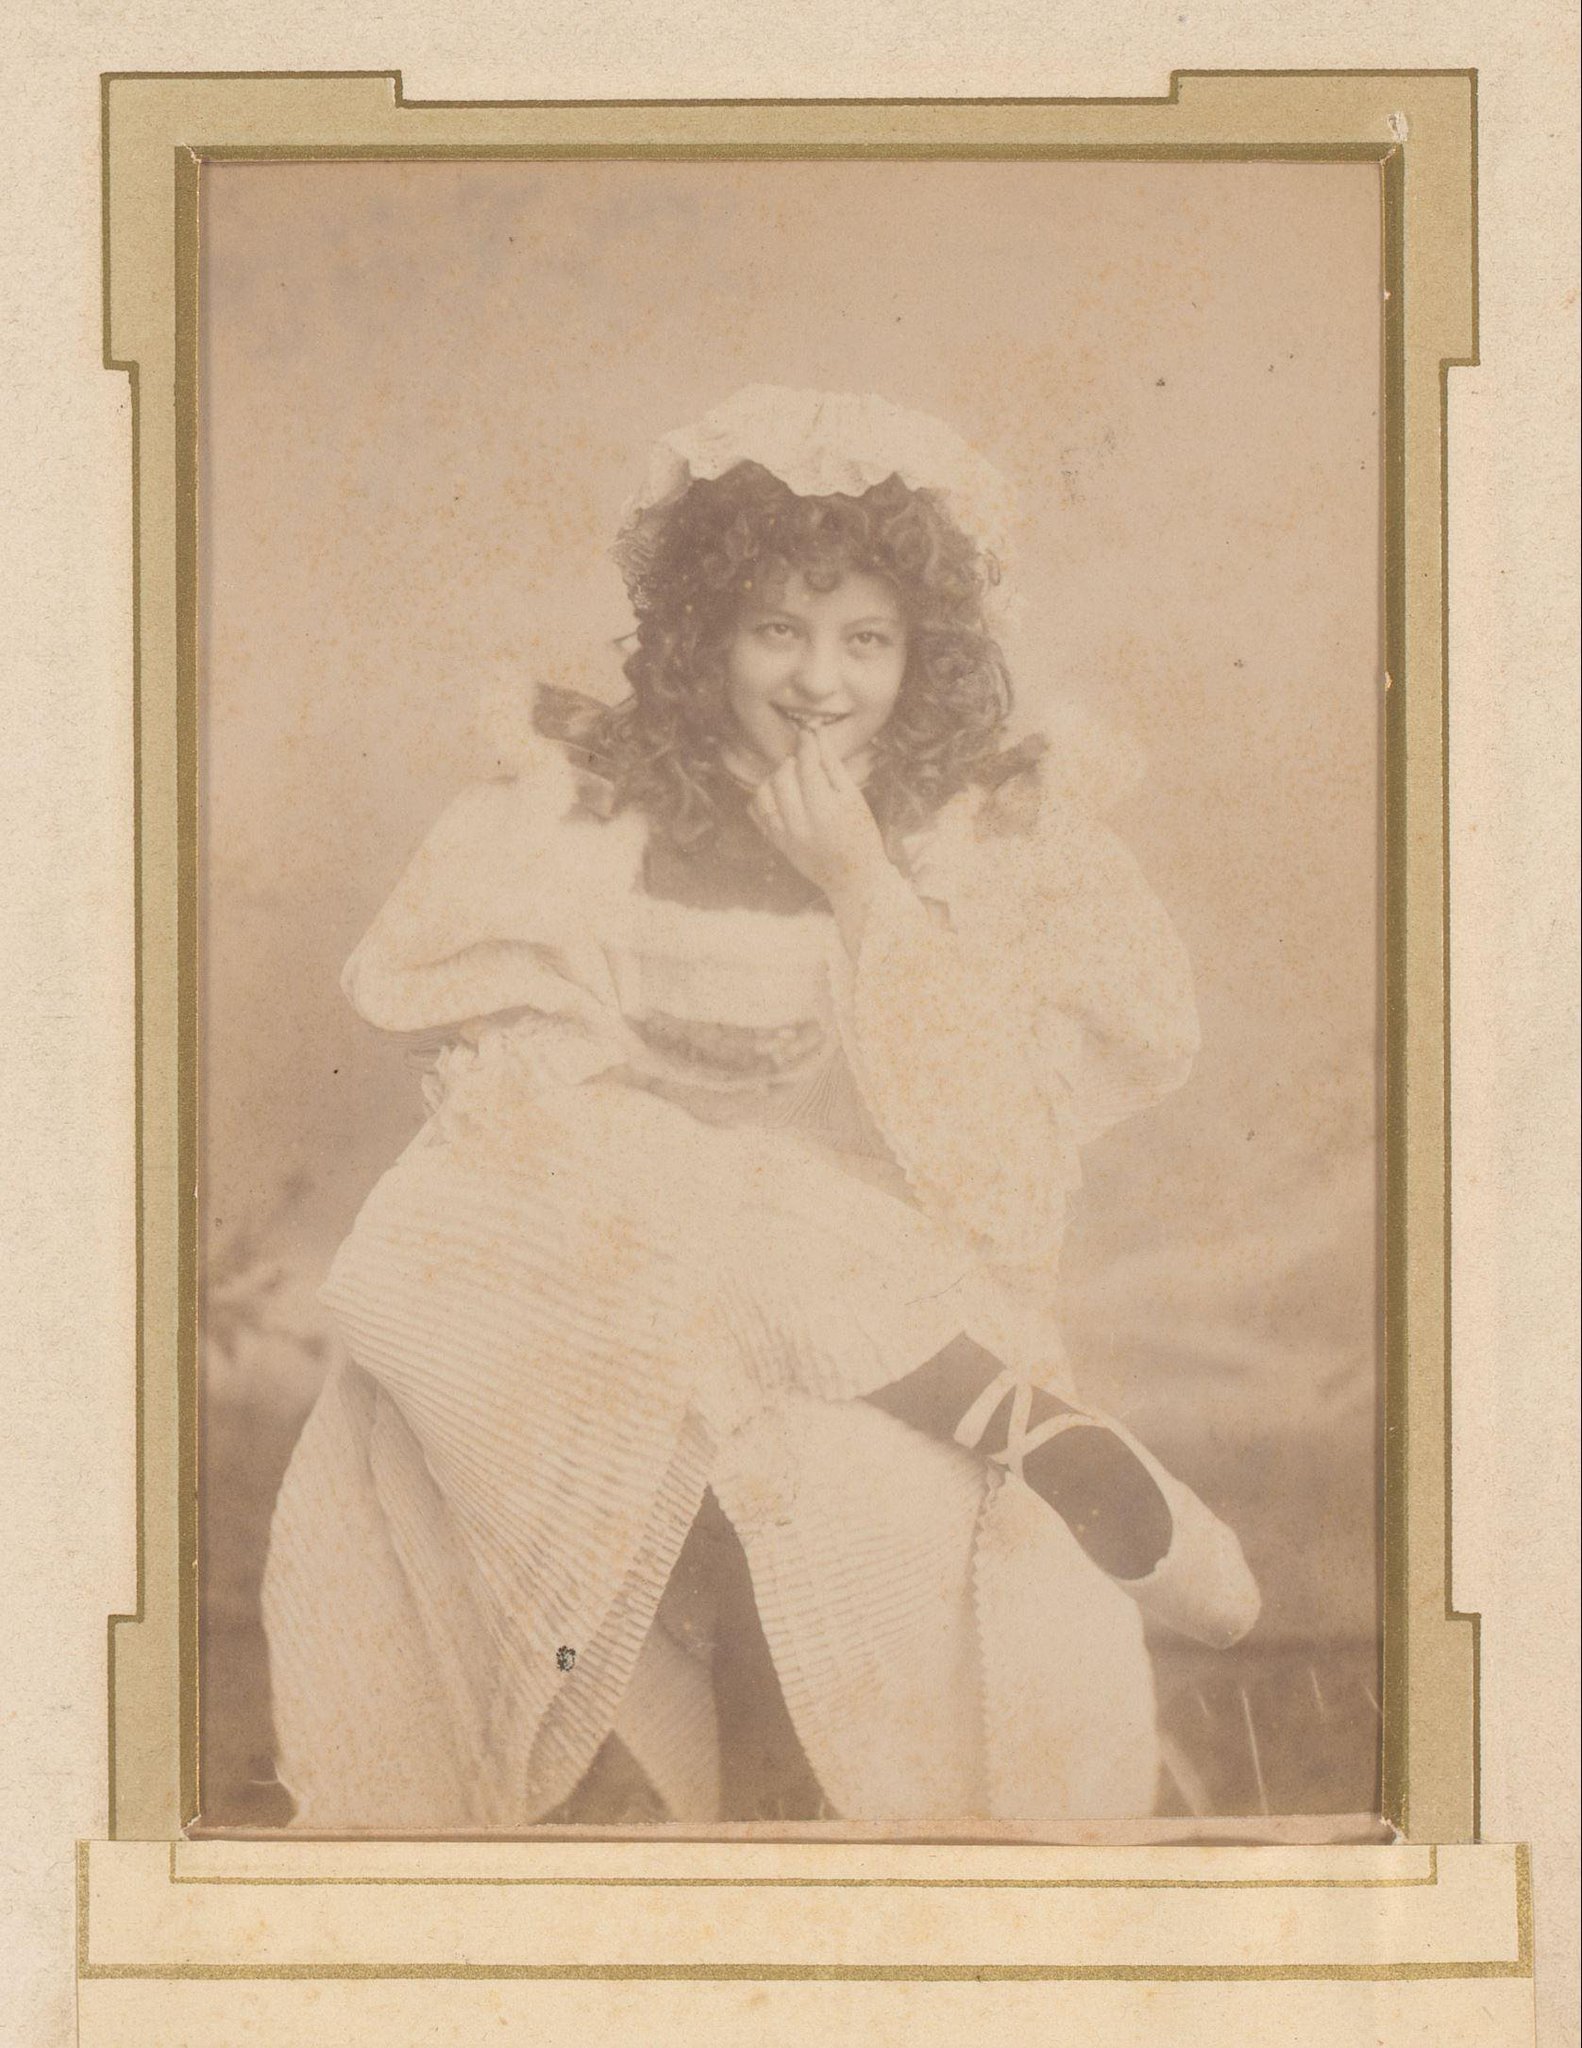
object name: cabinet photograph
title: Portret van een zittende vrouw in een witte jurk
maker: Anonymous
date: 1870-1900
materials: cardboard, photographic support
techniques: albumen print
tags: sitting figure - aa - female human figure, historical persons - bb - woman